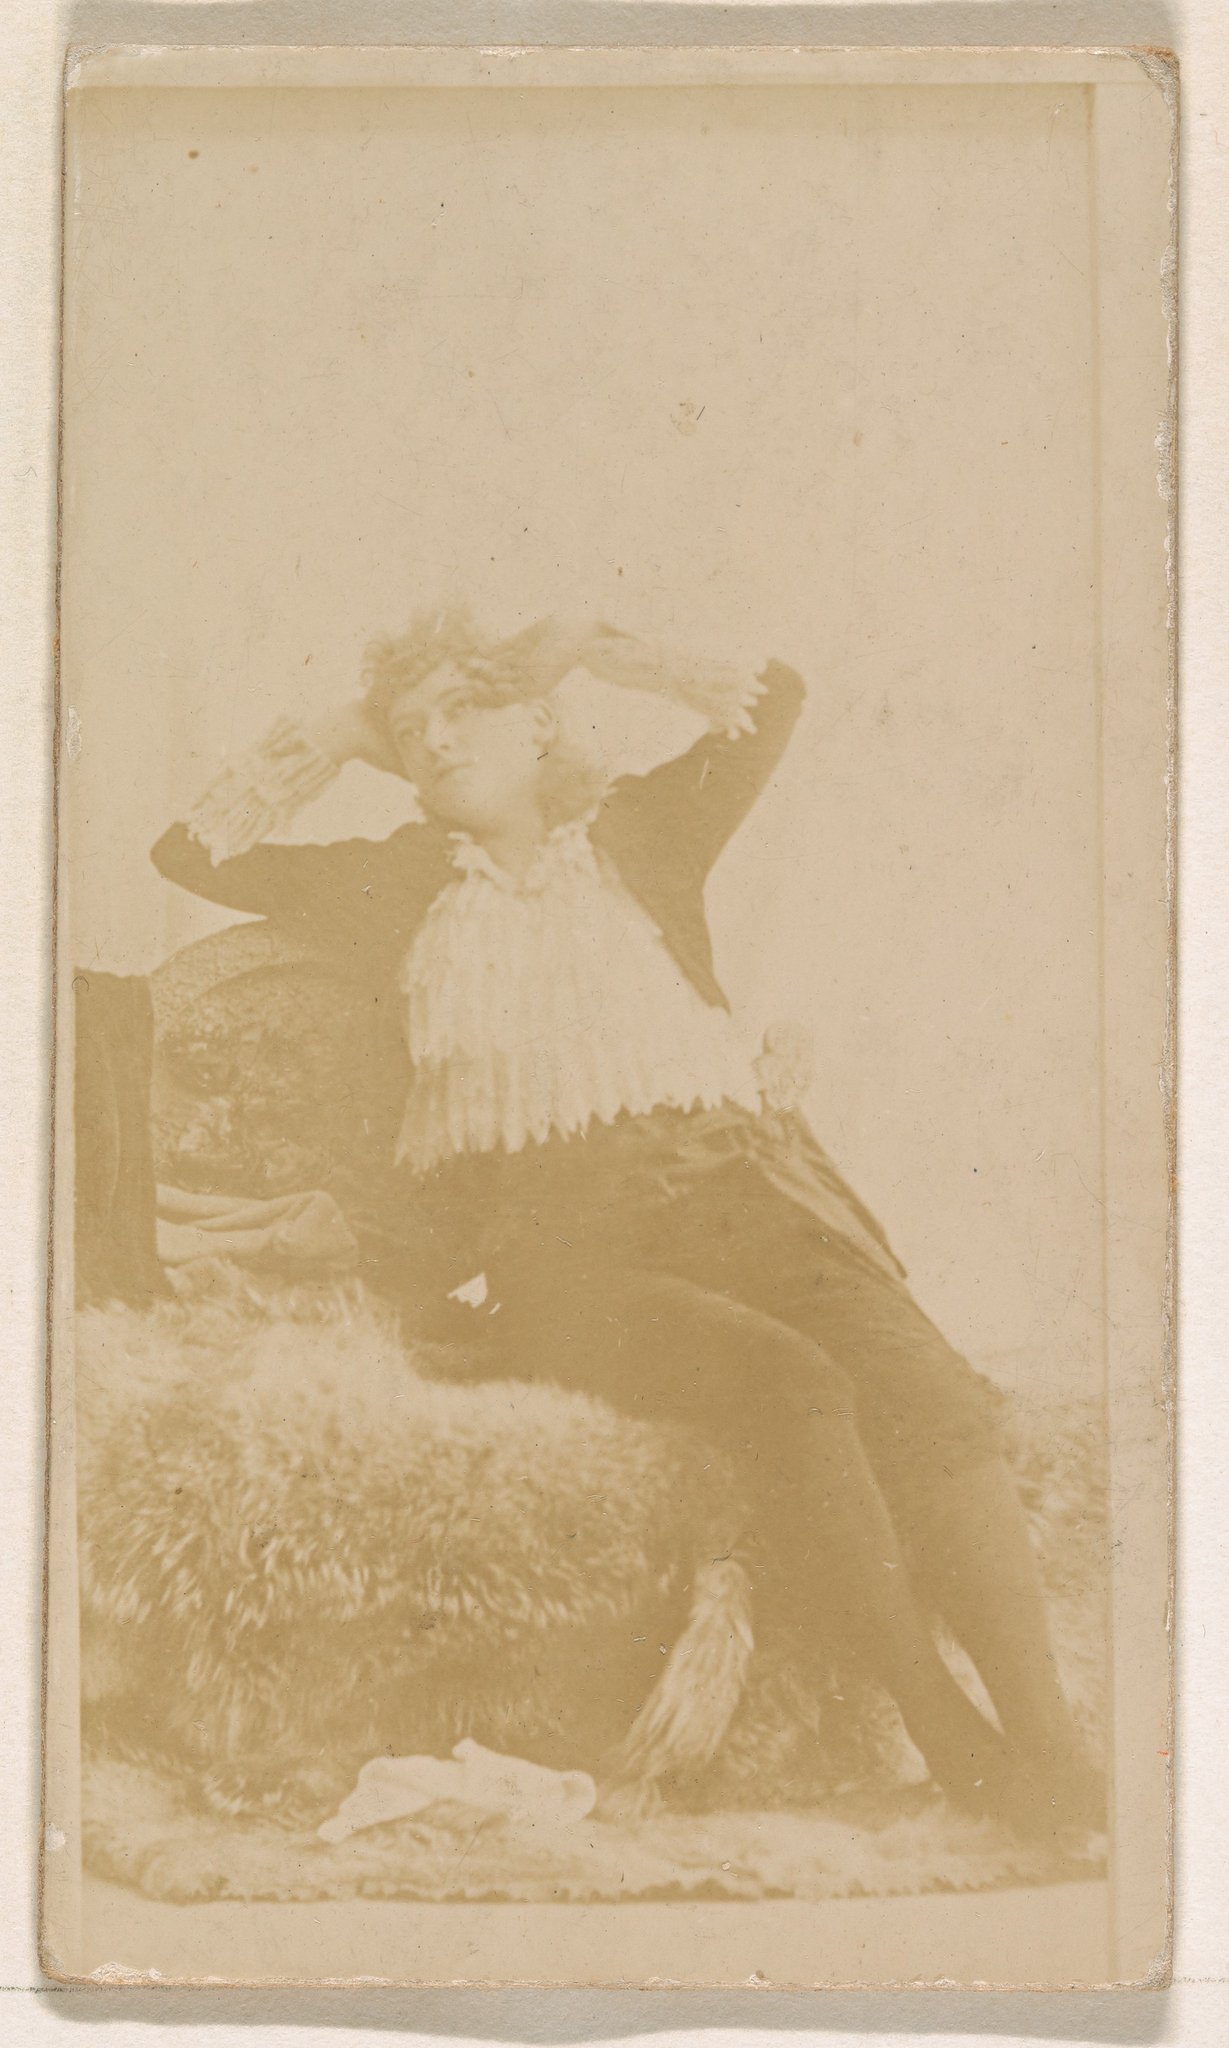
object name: photograph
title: Reclining actress, from the Actresses series (N245) issued by Kinney Brothers to promote Sweet Caporal Cigarettes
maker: kinney brothers tobacco company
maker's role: publisher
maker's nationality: american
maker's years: 1869-2011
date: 1890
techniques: albumen silver print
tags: portraits,women,actresses